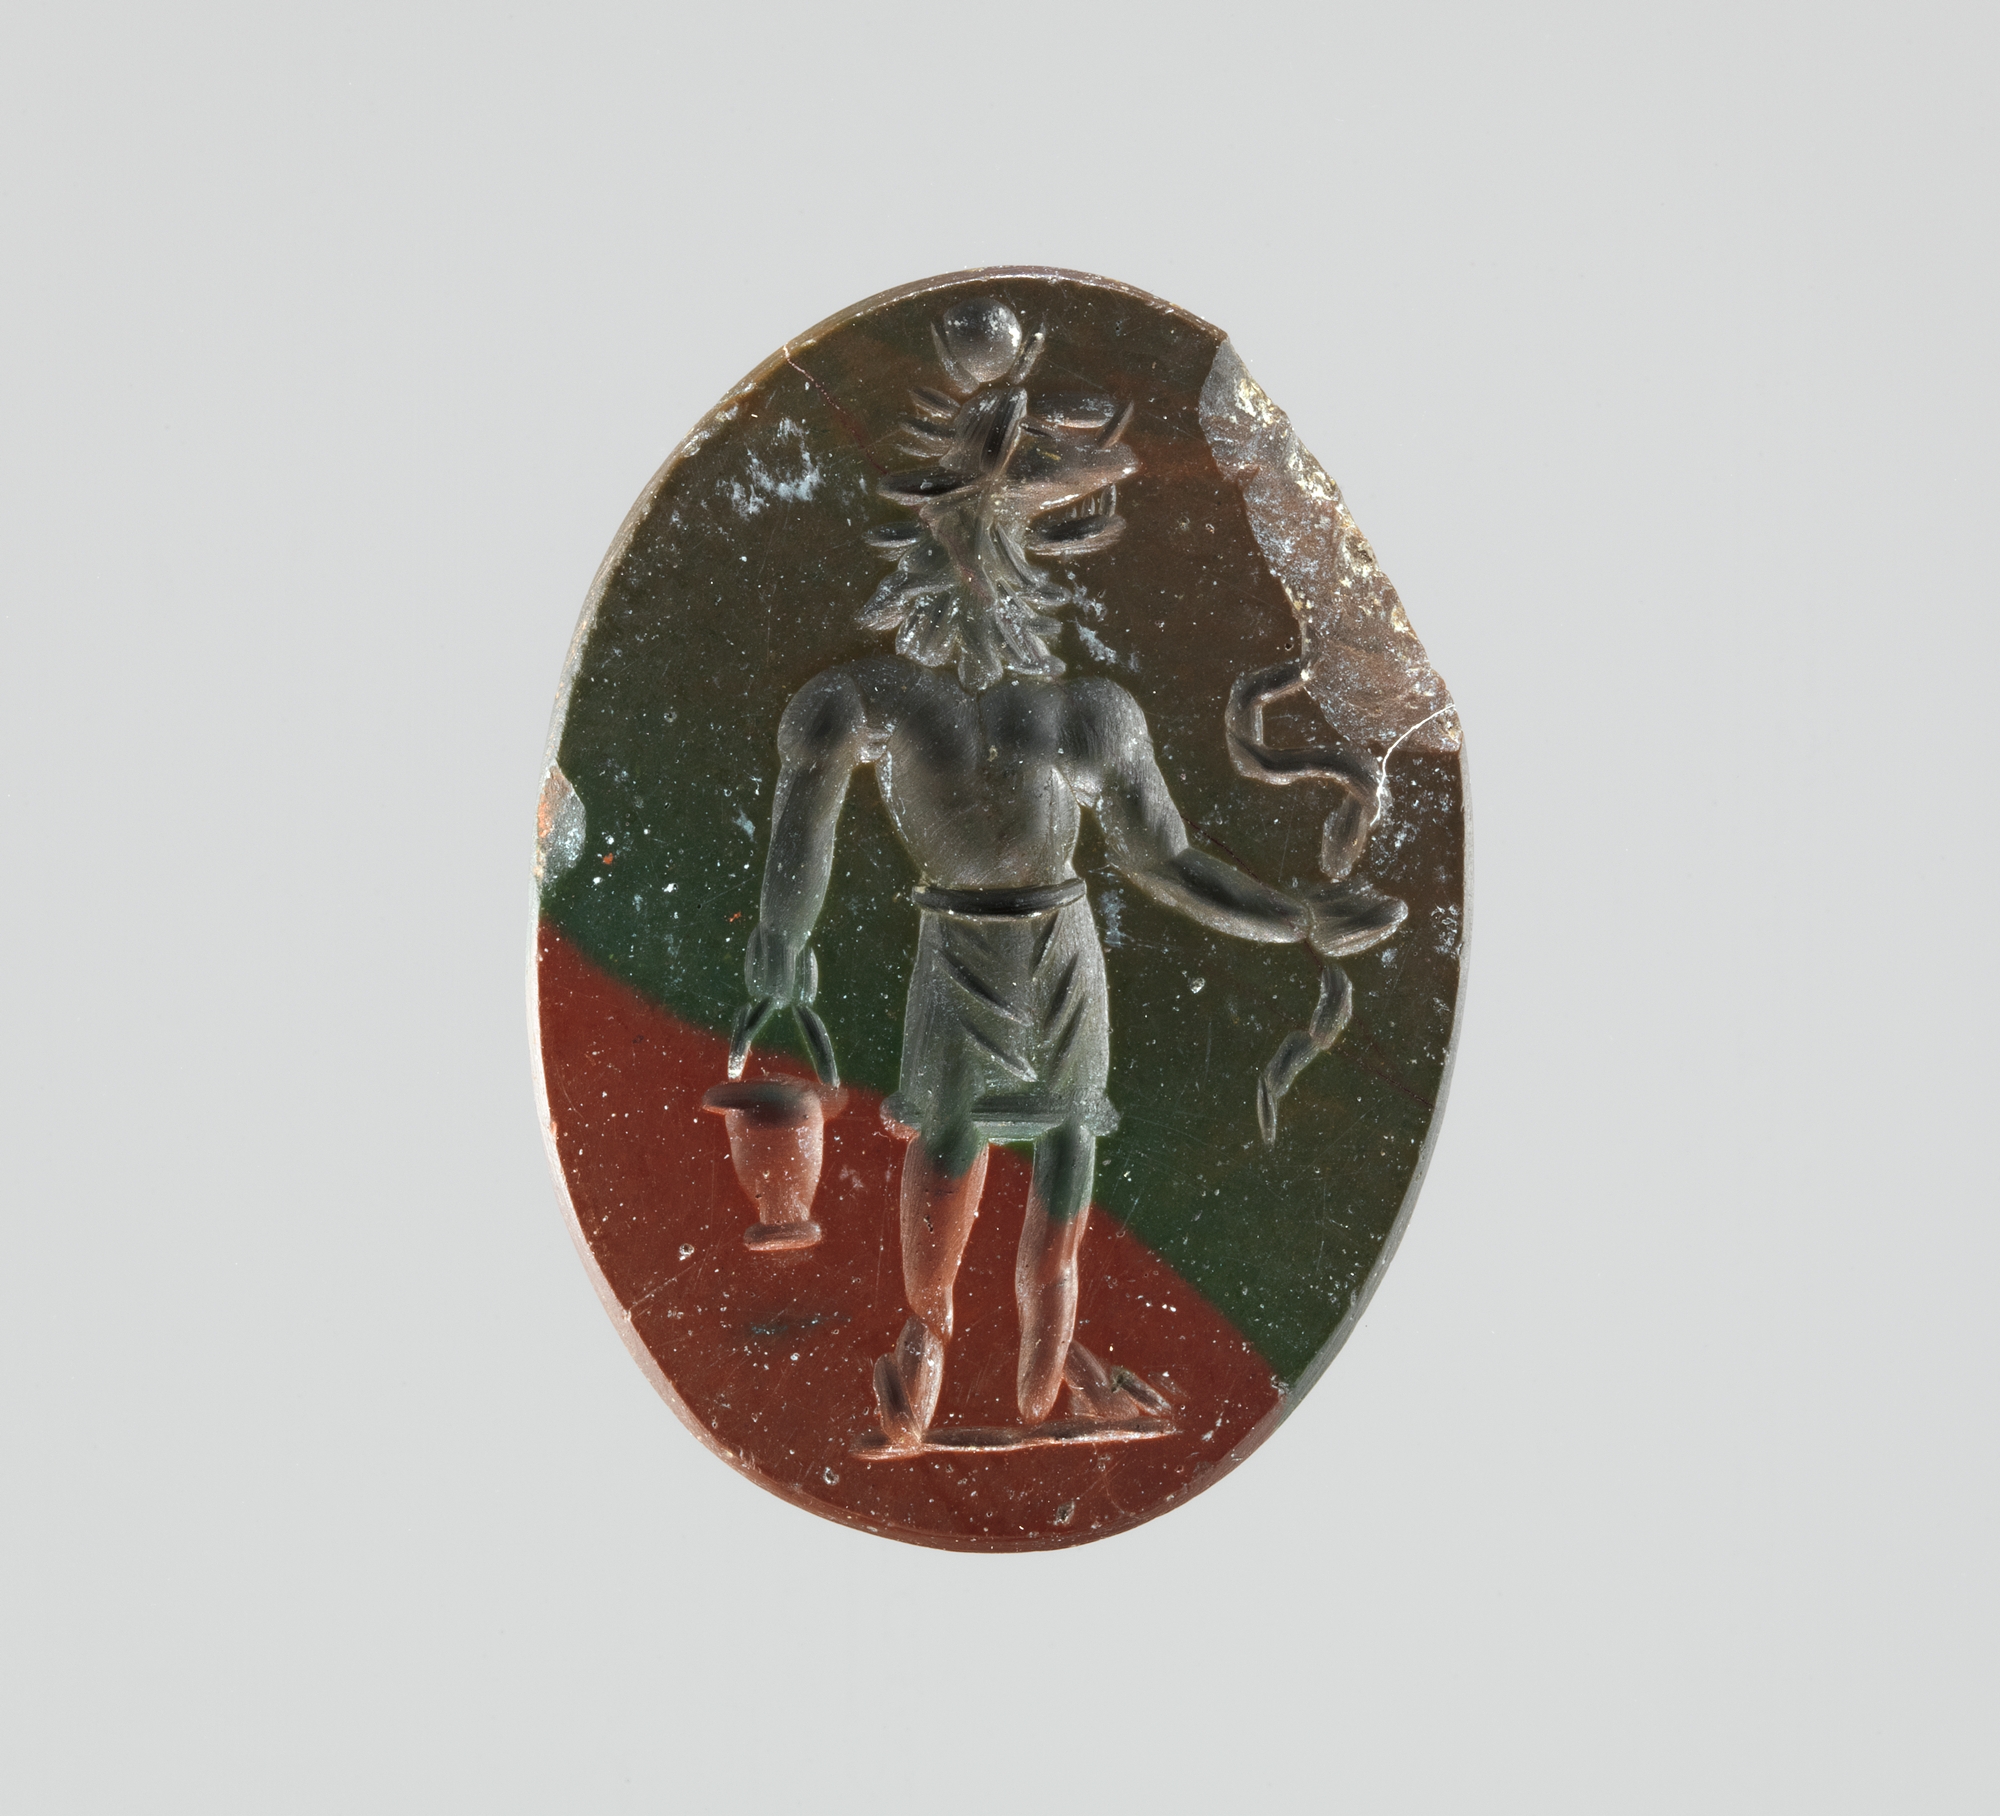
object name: intaglio, magical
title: Jasper intaglio: Lion-headed god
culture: roman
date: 101-300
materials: jasper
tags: lions,gods